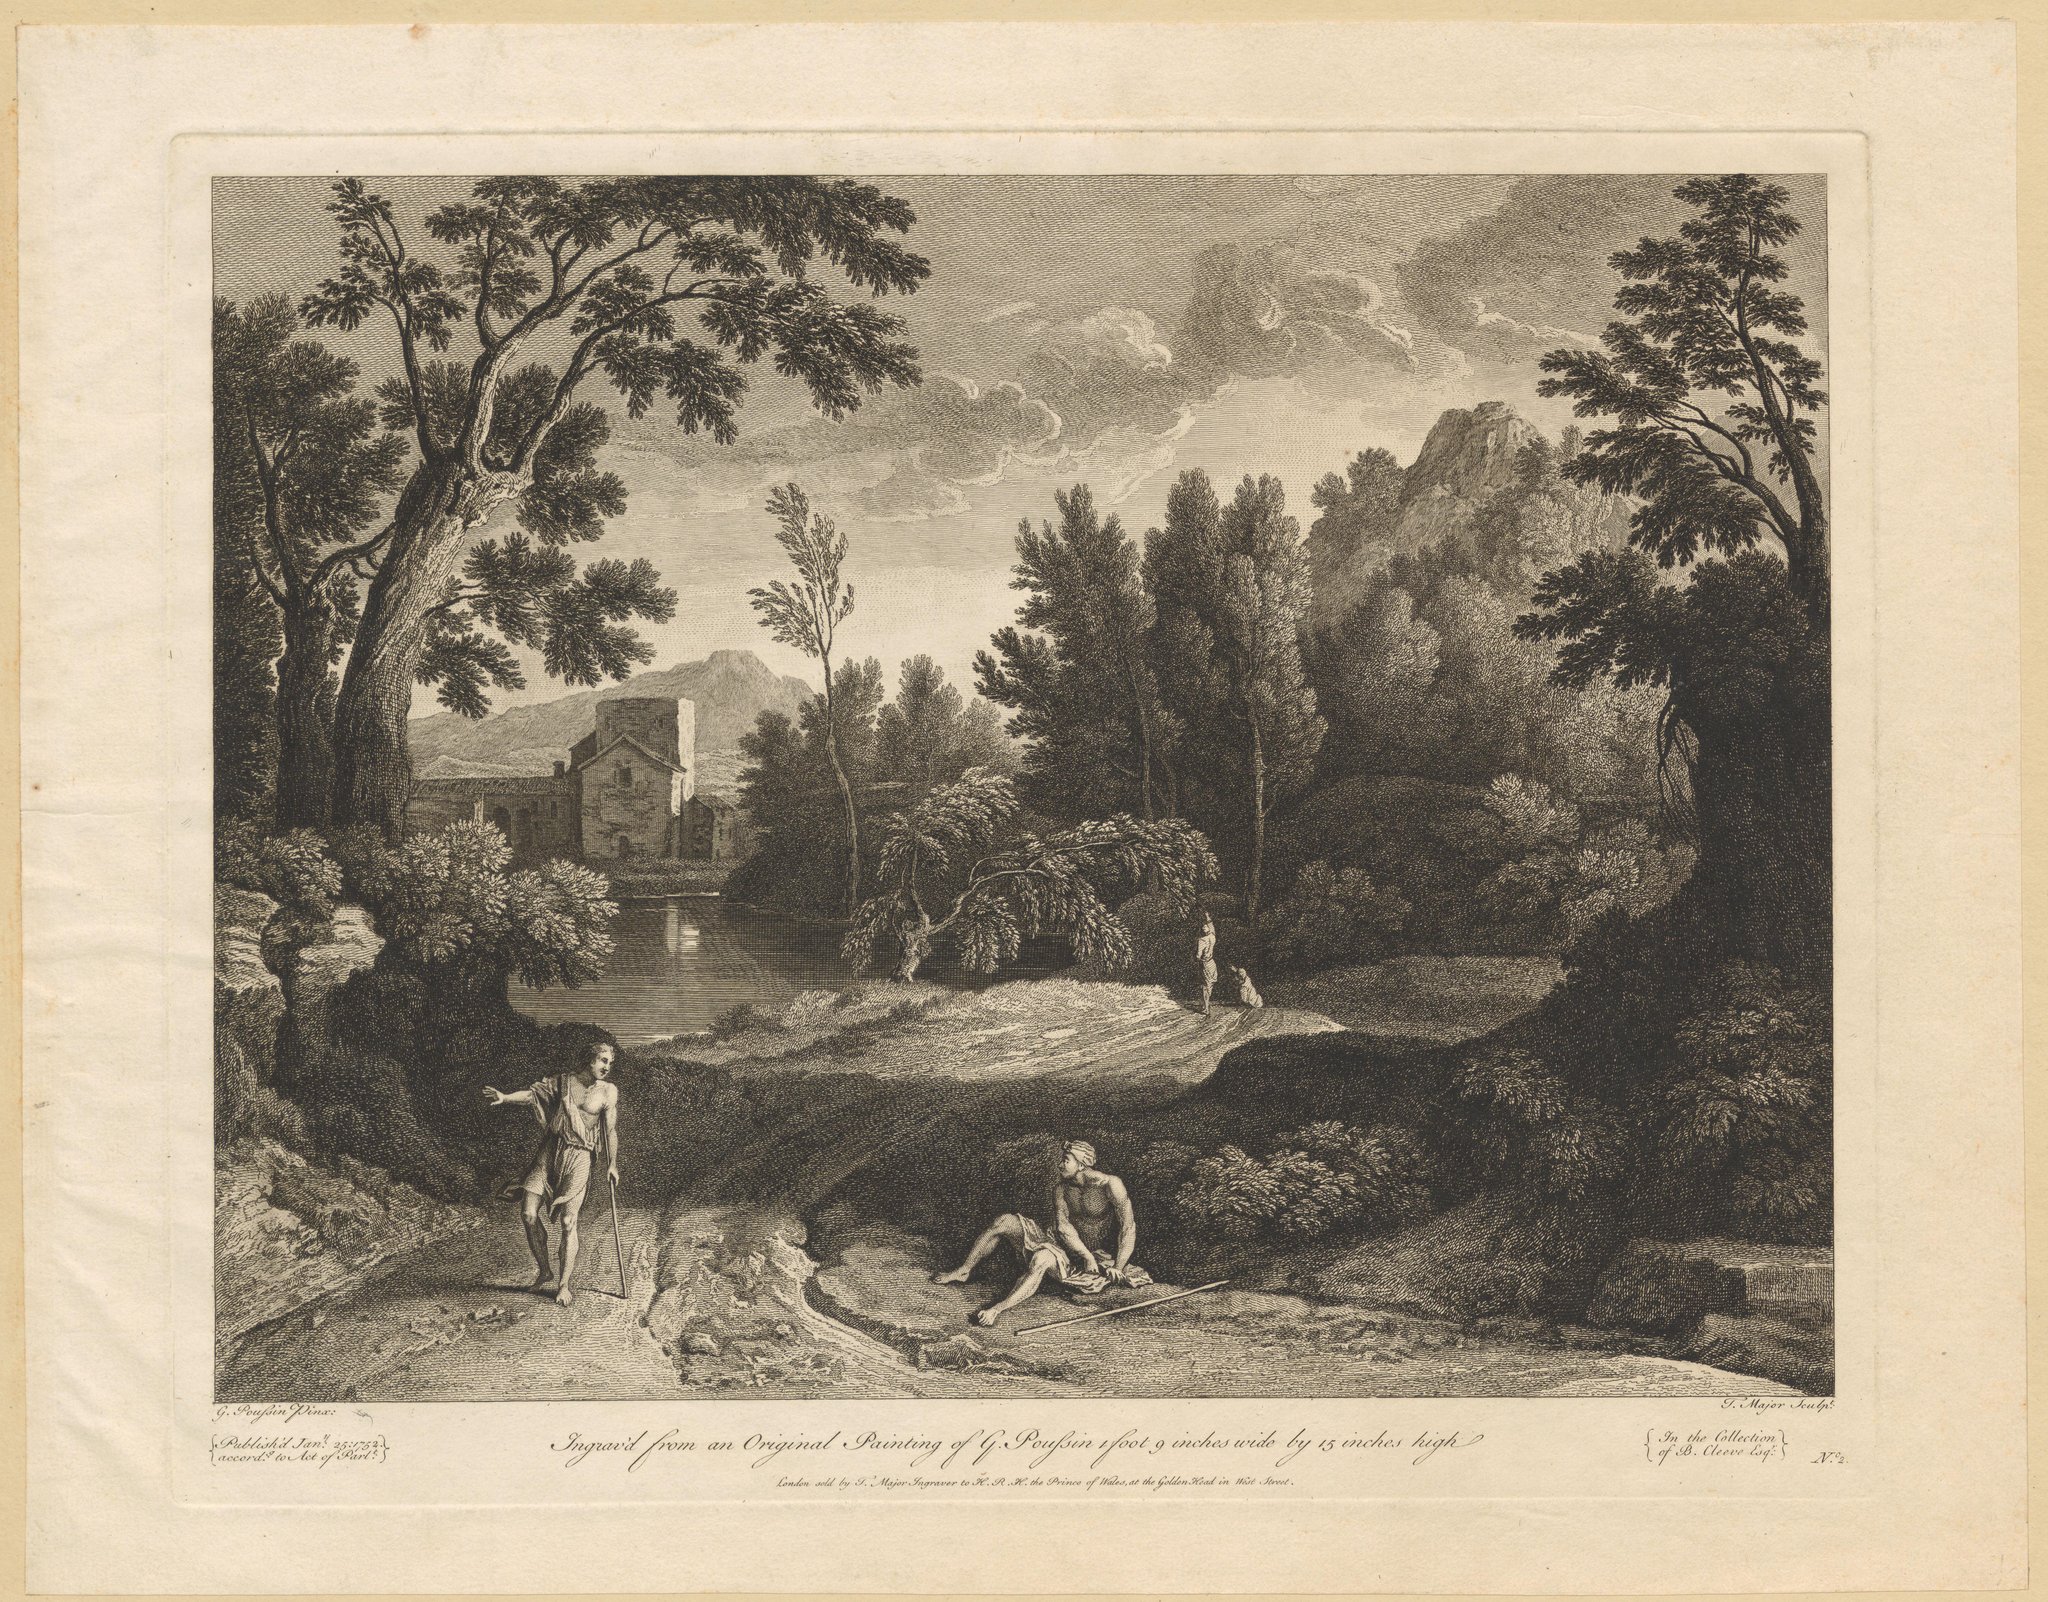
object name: print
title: Landschap met figuren op een pad langs een meer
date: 1752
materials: paper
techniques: etching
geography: london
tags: (traveller) resting in the open air, 'en route', traveller under way, lake (+ landscape with figures, staffage)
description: Tekst in het Engels in de ondermarge. Genummerd: 2